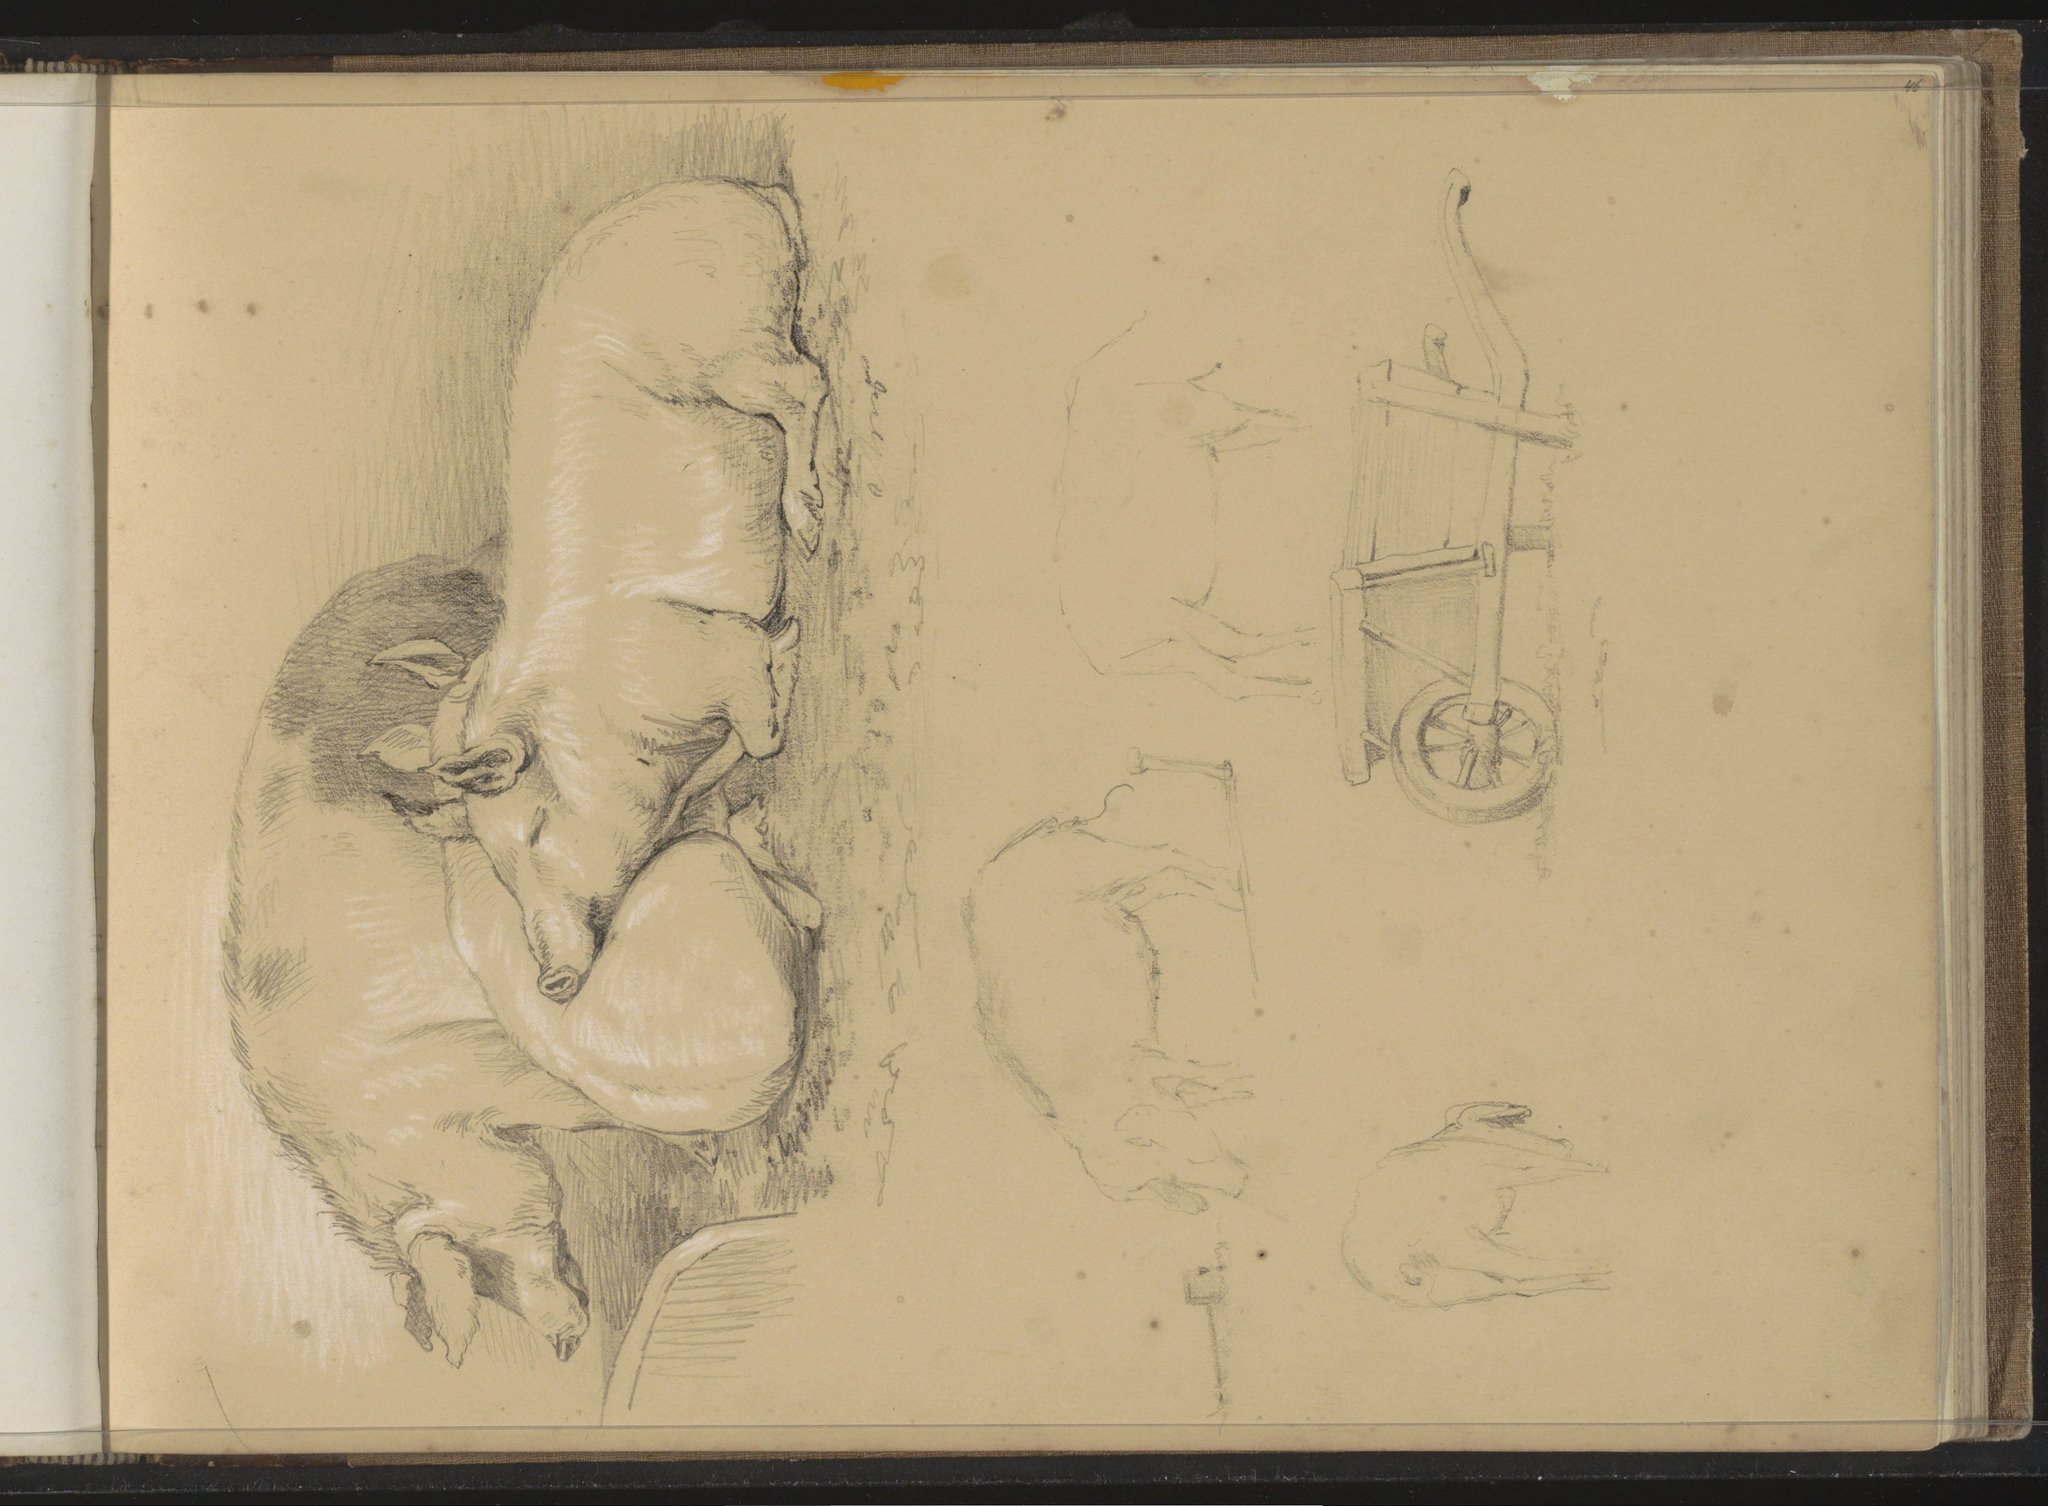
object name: sketchbook leaf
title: Varkens en een handkar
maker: hendrik valkenburg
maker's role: draughtsman, painter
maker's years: 1826-1896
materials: chalk, paper, pencil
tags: hand-cart, pig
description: Blad 46 recto uit een schetsboek met 77 bladen.